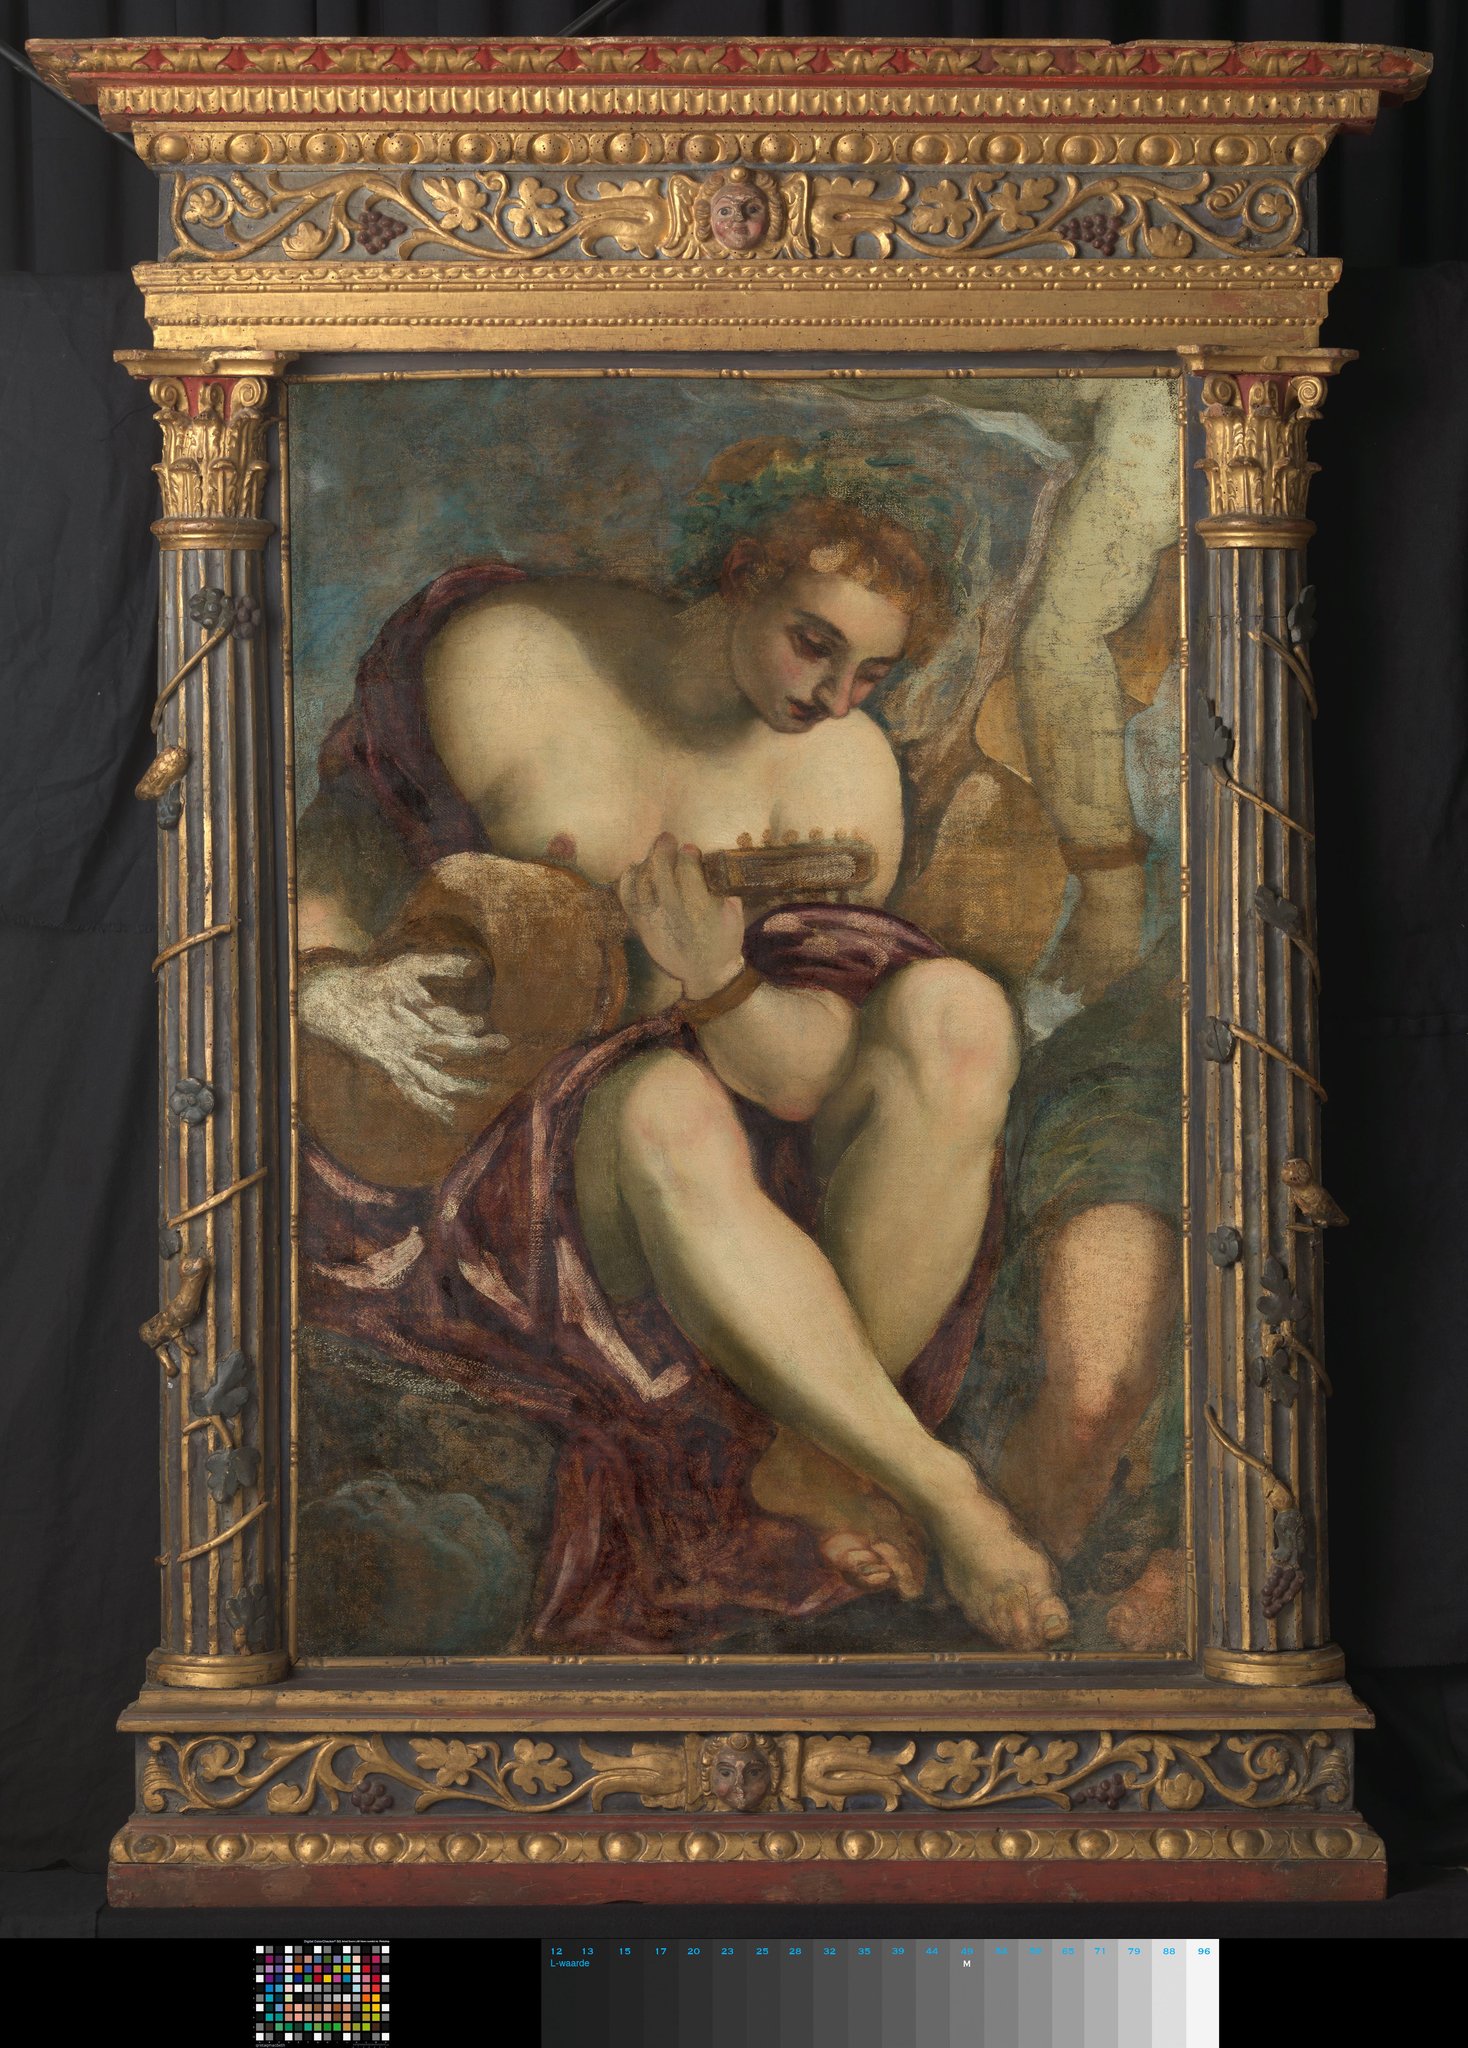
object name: frame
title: Gesneden, vergulde en veelkleurig beschilderde aediculalijst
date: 1400-1950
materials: wood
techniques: cutting, gilding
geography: italy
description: Gesneden aediculalijst. Het bovengestel heeft een vlakke bovenkant, daaronder een soort eierlijst, dan een rand met een eenvoudig acanthusbladmotief, een rand met hele korte cannelures en een soort eierlijst. Daaronder zit een fries met een vergulde engelenkop met aan weerszijden druivenranken op een blauwe ondergrond. Het ondergestel heeft geen afzaat maar een horizontale bovenkant. Daaronder zit een holle, vergulde rand, dan een fries met een vergulde engelenkop met aan weerszijden druivenranken op een blauwe ondergrond, daaronder een vergulde eierlijst en een vlakke rand. De stijlen bestaan uit vergulde ionische zuilen met donker gekleurde cannelures en omwikkeld met bladranken waarop vergulde vogels zitten. De bladranken en de vogels zijn erg beschadigd. Om de dagkant zitten een vlakke rand en een rand met een vergulde, onderbroken tweelingparel. De lijst is beschadigd en zit vol houtwormgaatjes.